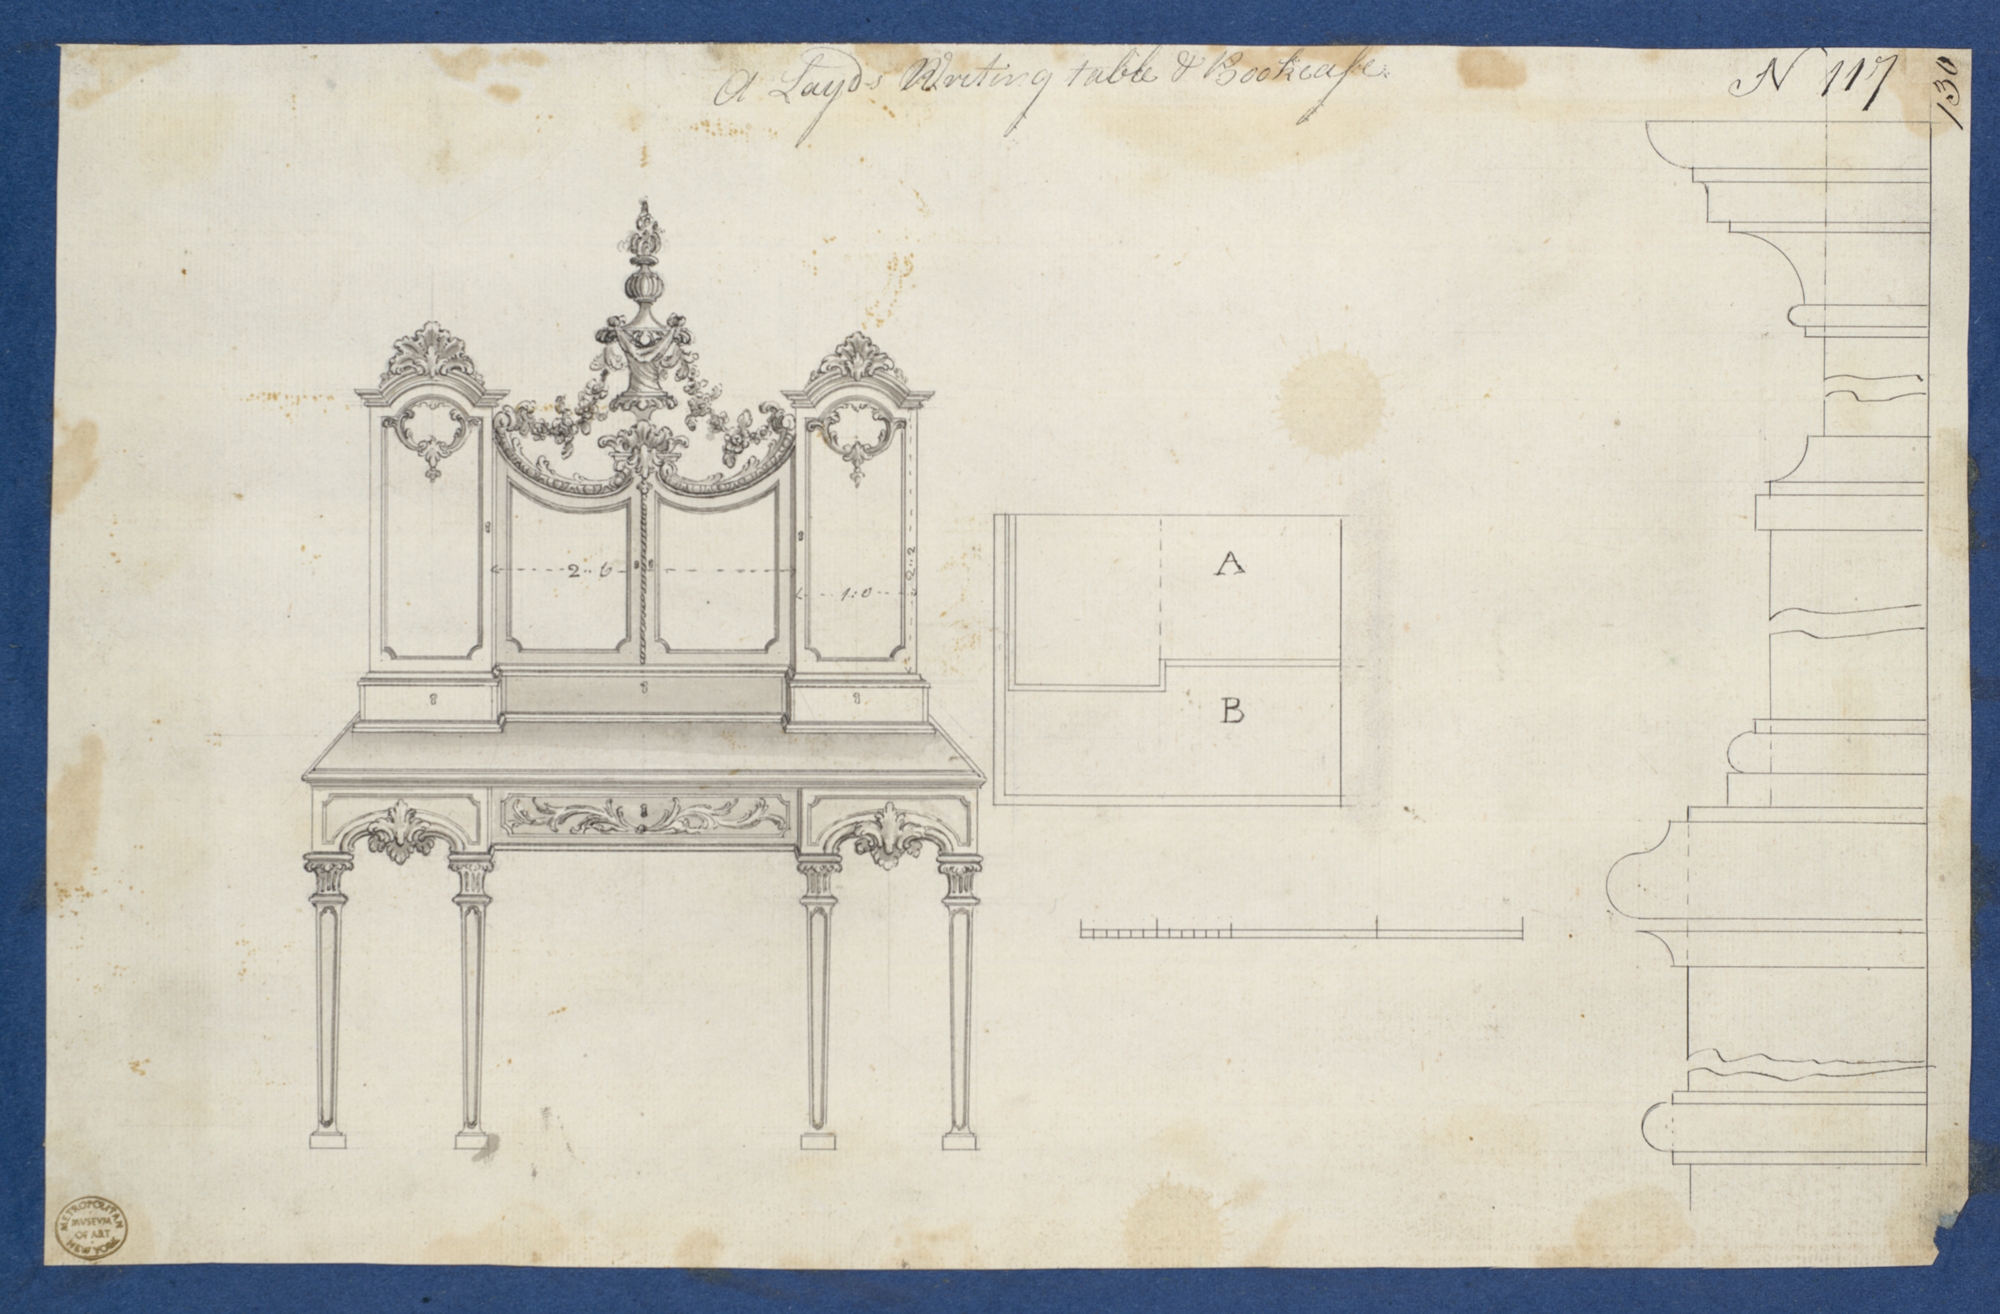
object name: drawing ornament architecture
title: Lady's Writing Table and Bookcase, from Chippendale Drawings, Vol. II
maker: thomas chippendale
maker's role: artist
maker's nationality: british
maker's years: 1718-1779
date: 1760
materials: ink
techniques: wash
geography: london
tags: tables